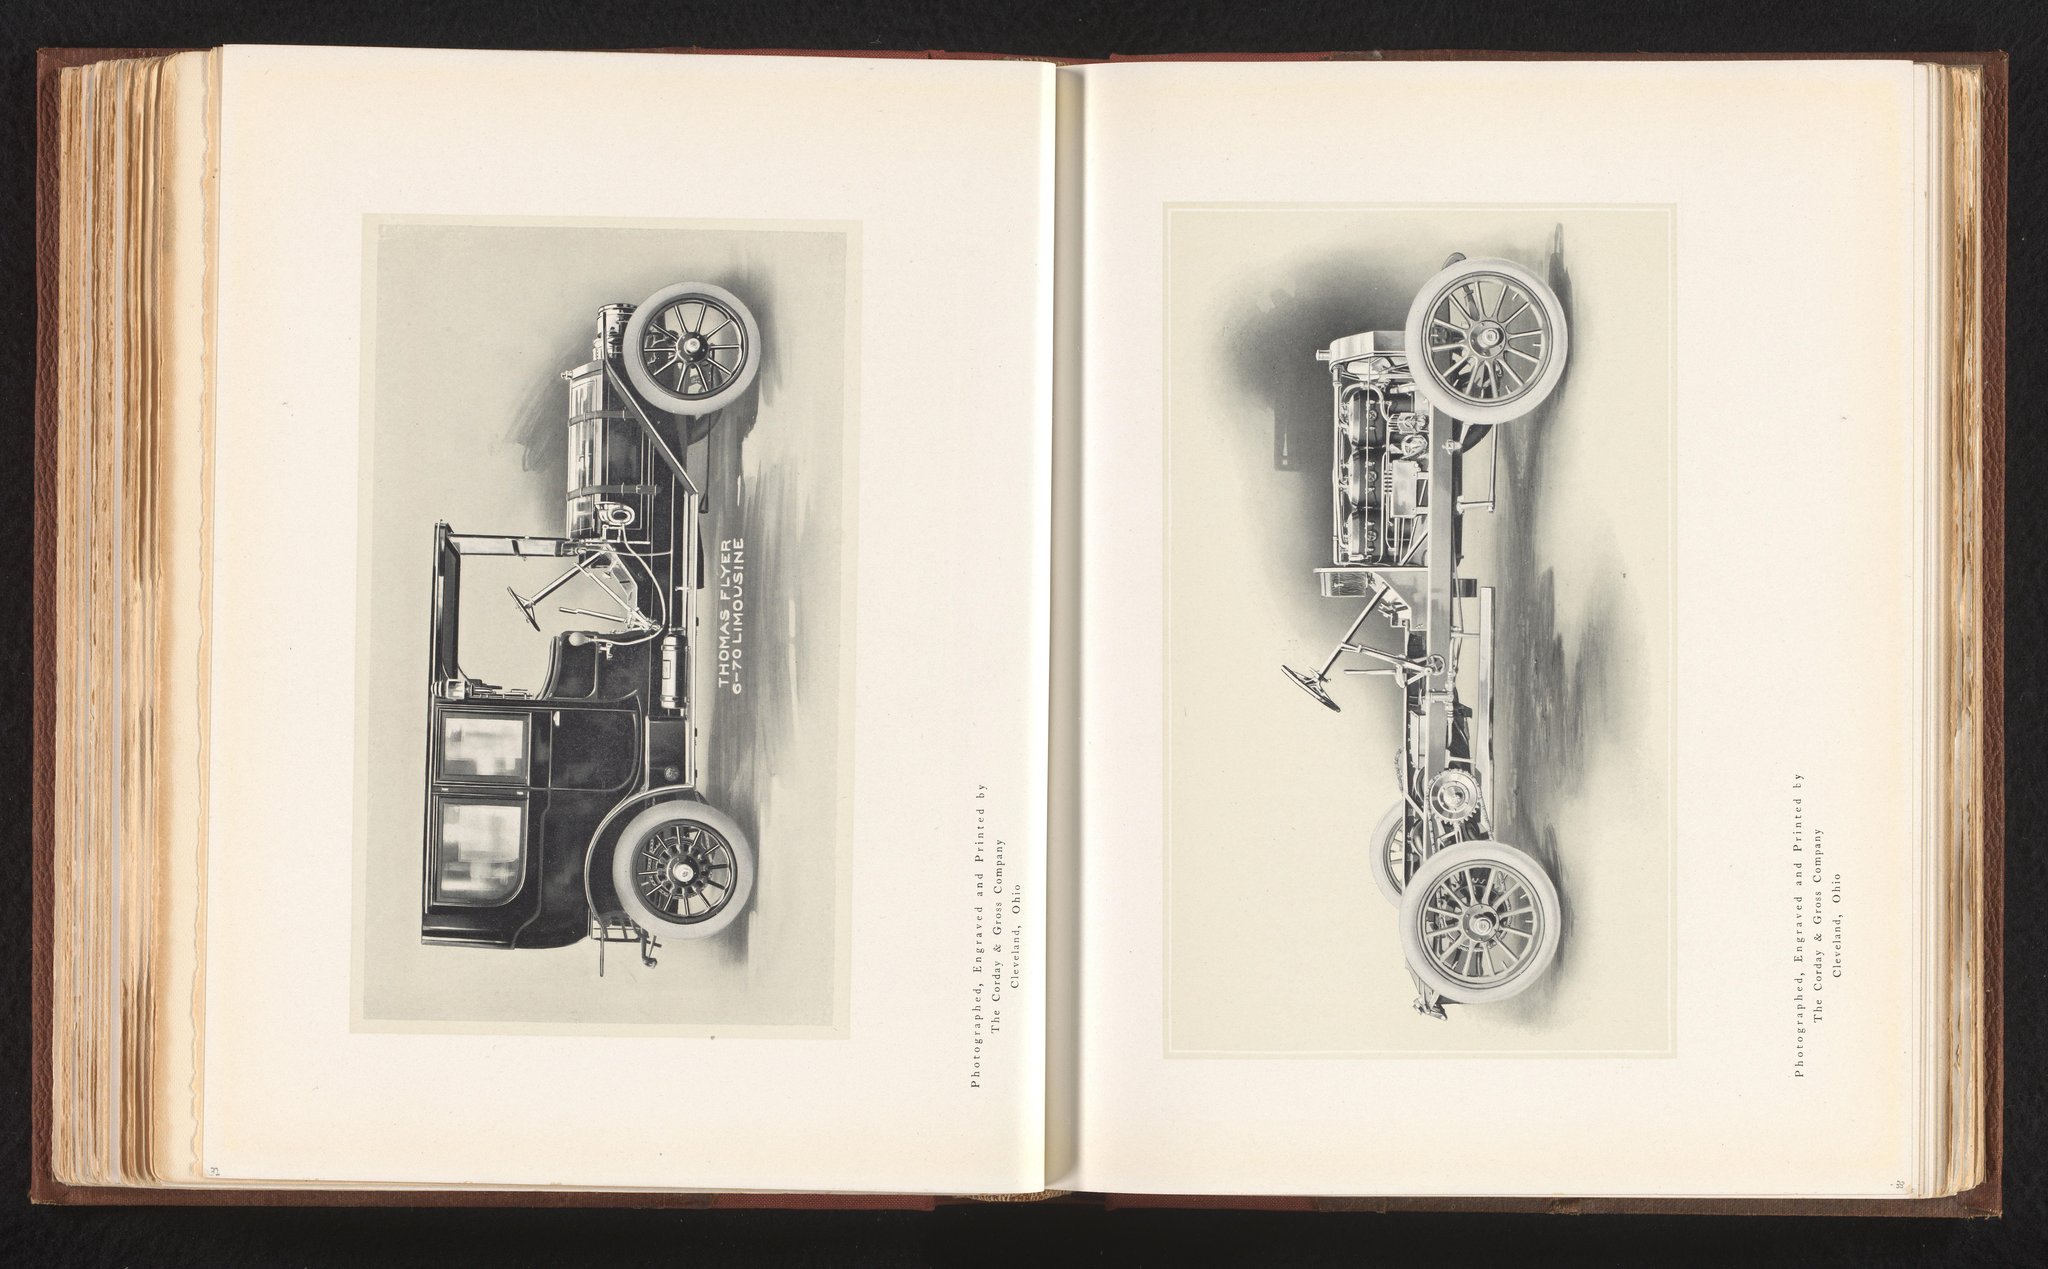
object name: photomechanical print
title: Opengewerkt model van een auto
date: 1904-1909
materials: paper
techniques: autotype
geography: ohio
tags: automobile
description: Prent op zesde ongenummerde pagina na pagina 213.